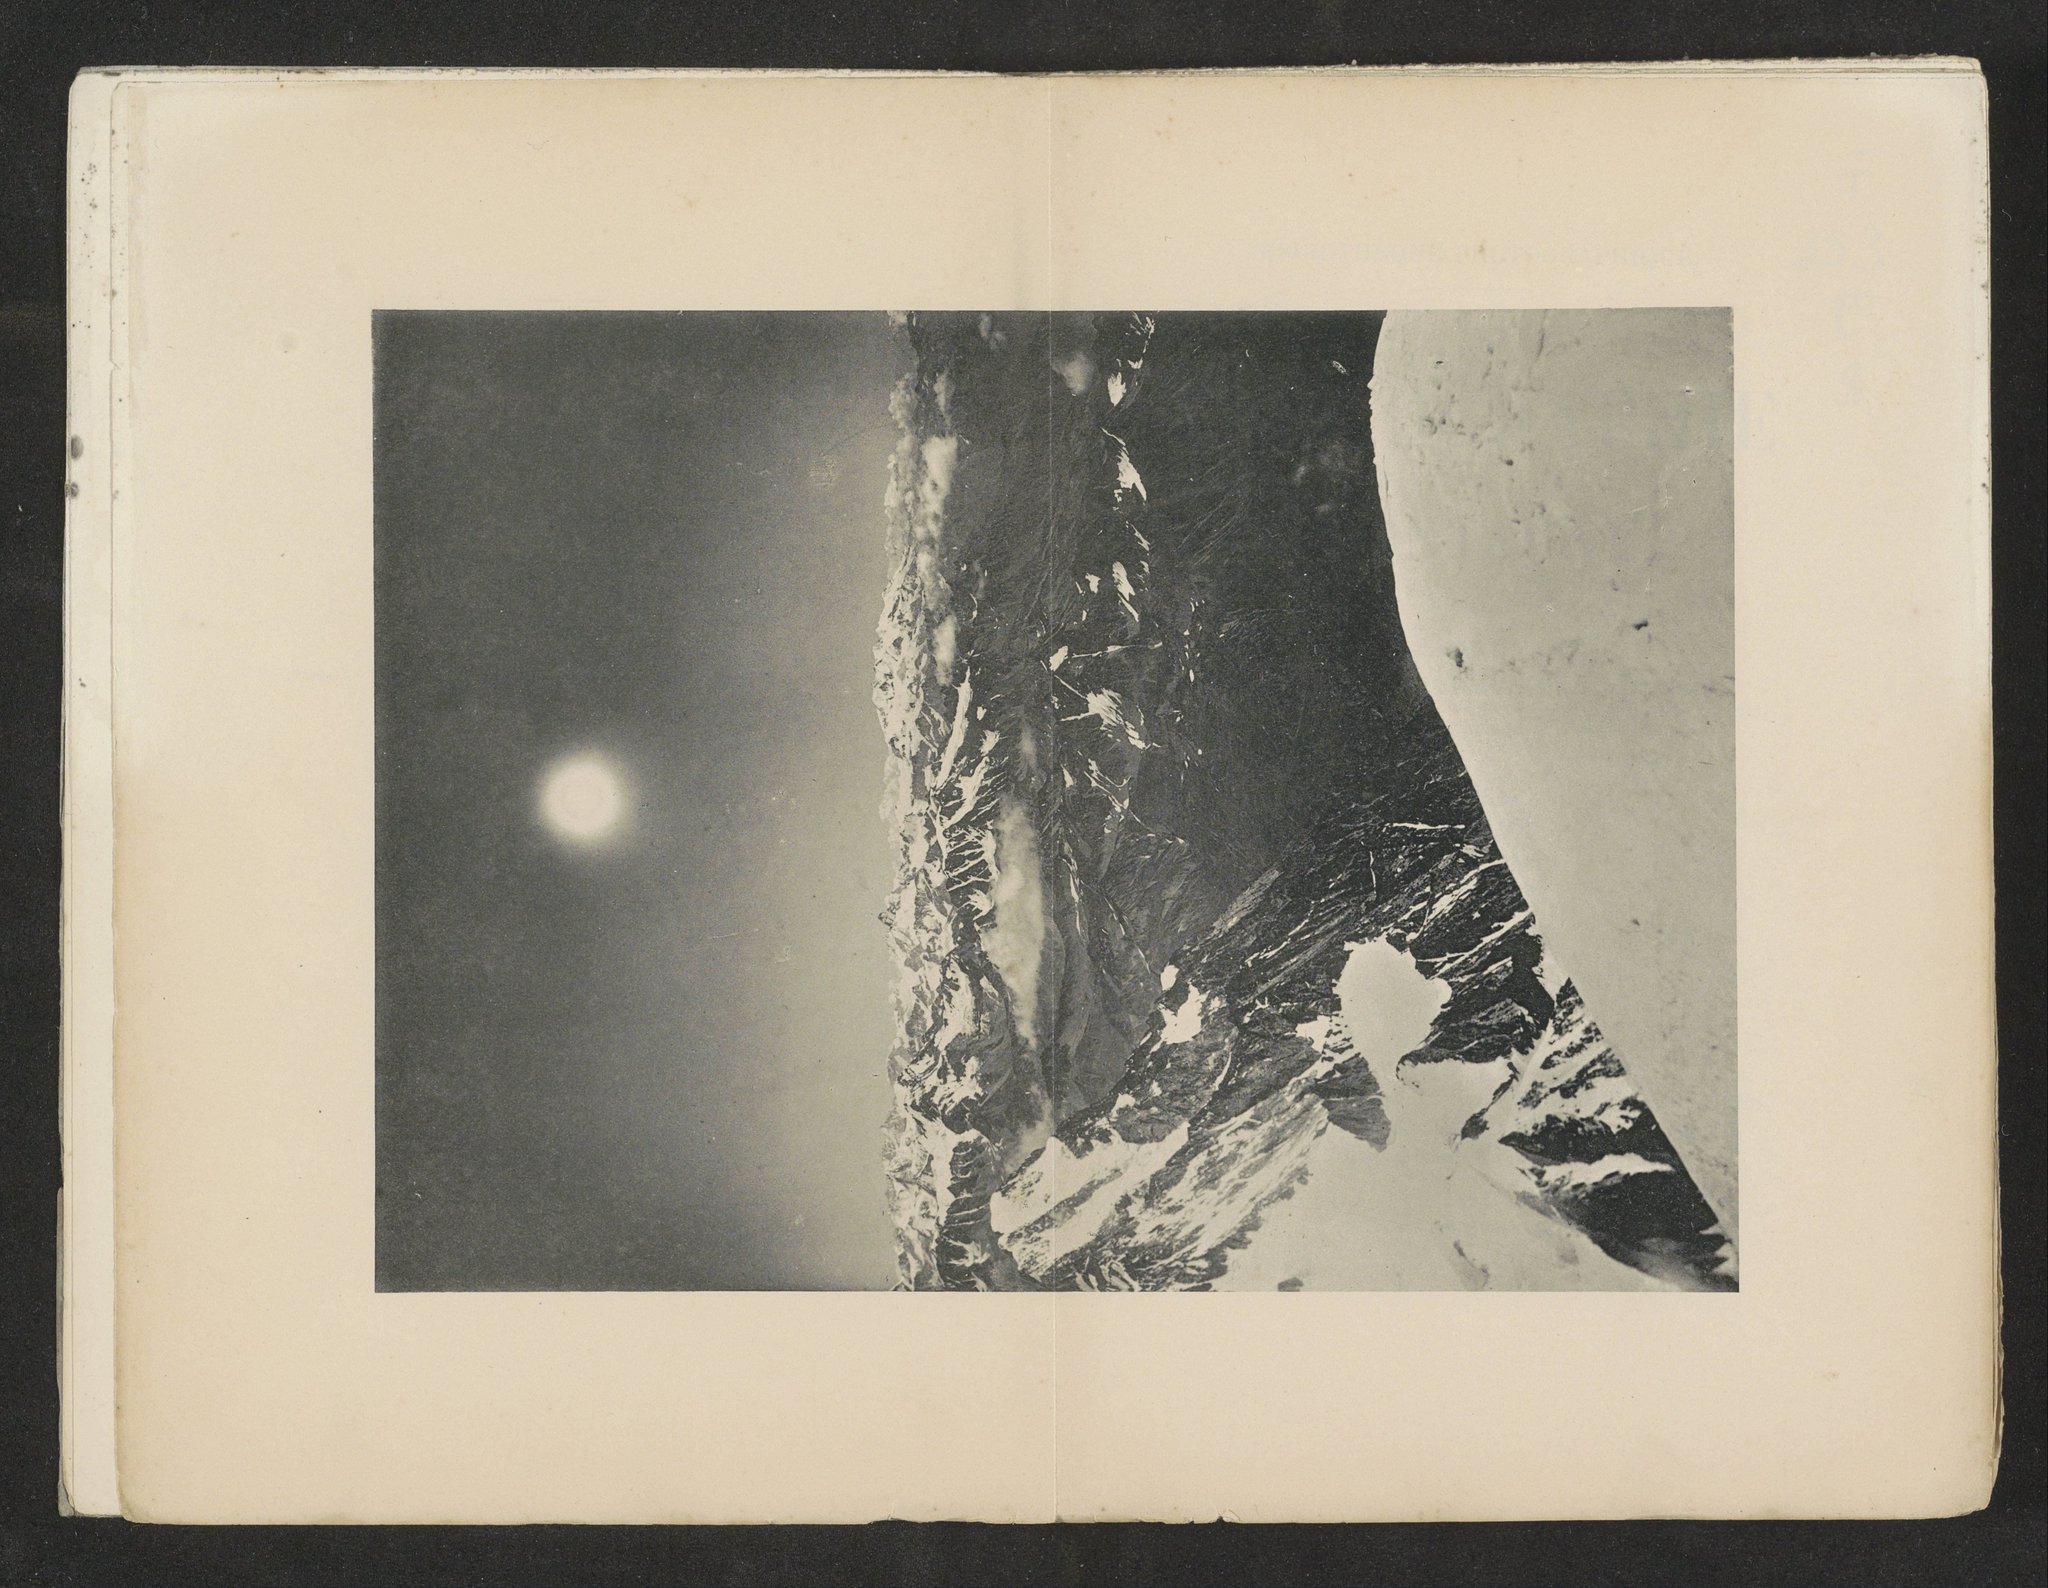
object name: photomechanical print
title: Vue du Mont Rose et du Cervin prise du sommet du Mont Blanc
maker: j. vallot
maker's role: fotograaf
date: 1884-1894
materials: paper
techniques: photograph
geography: mont blanc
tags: mountains